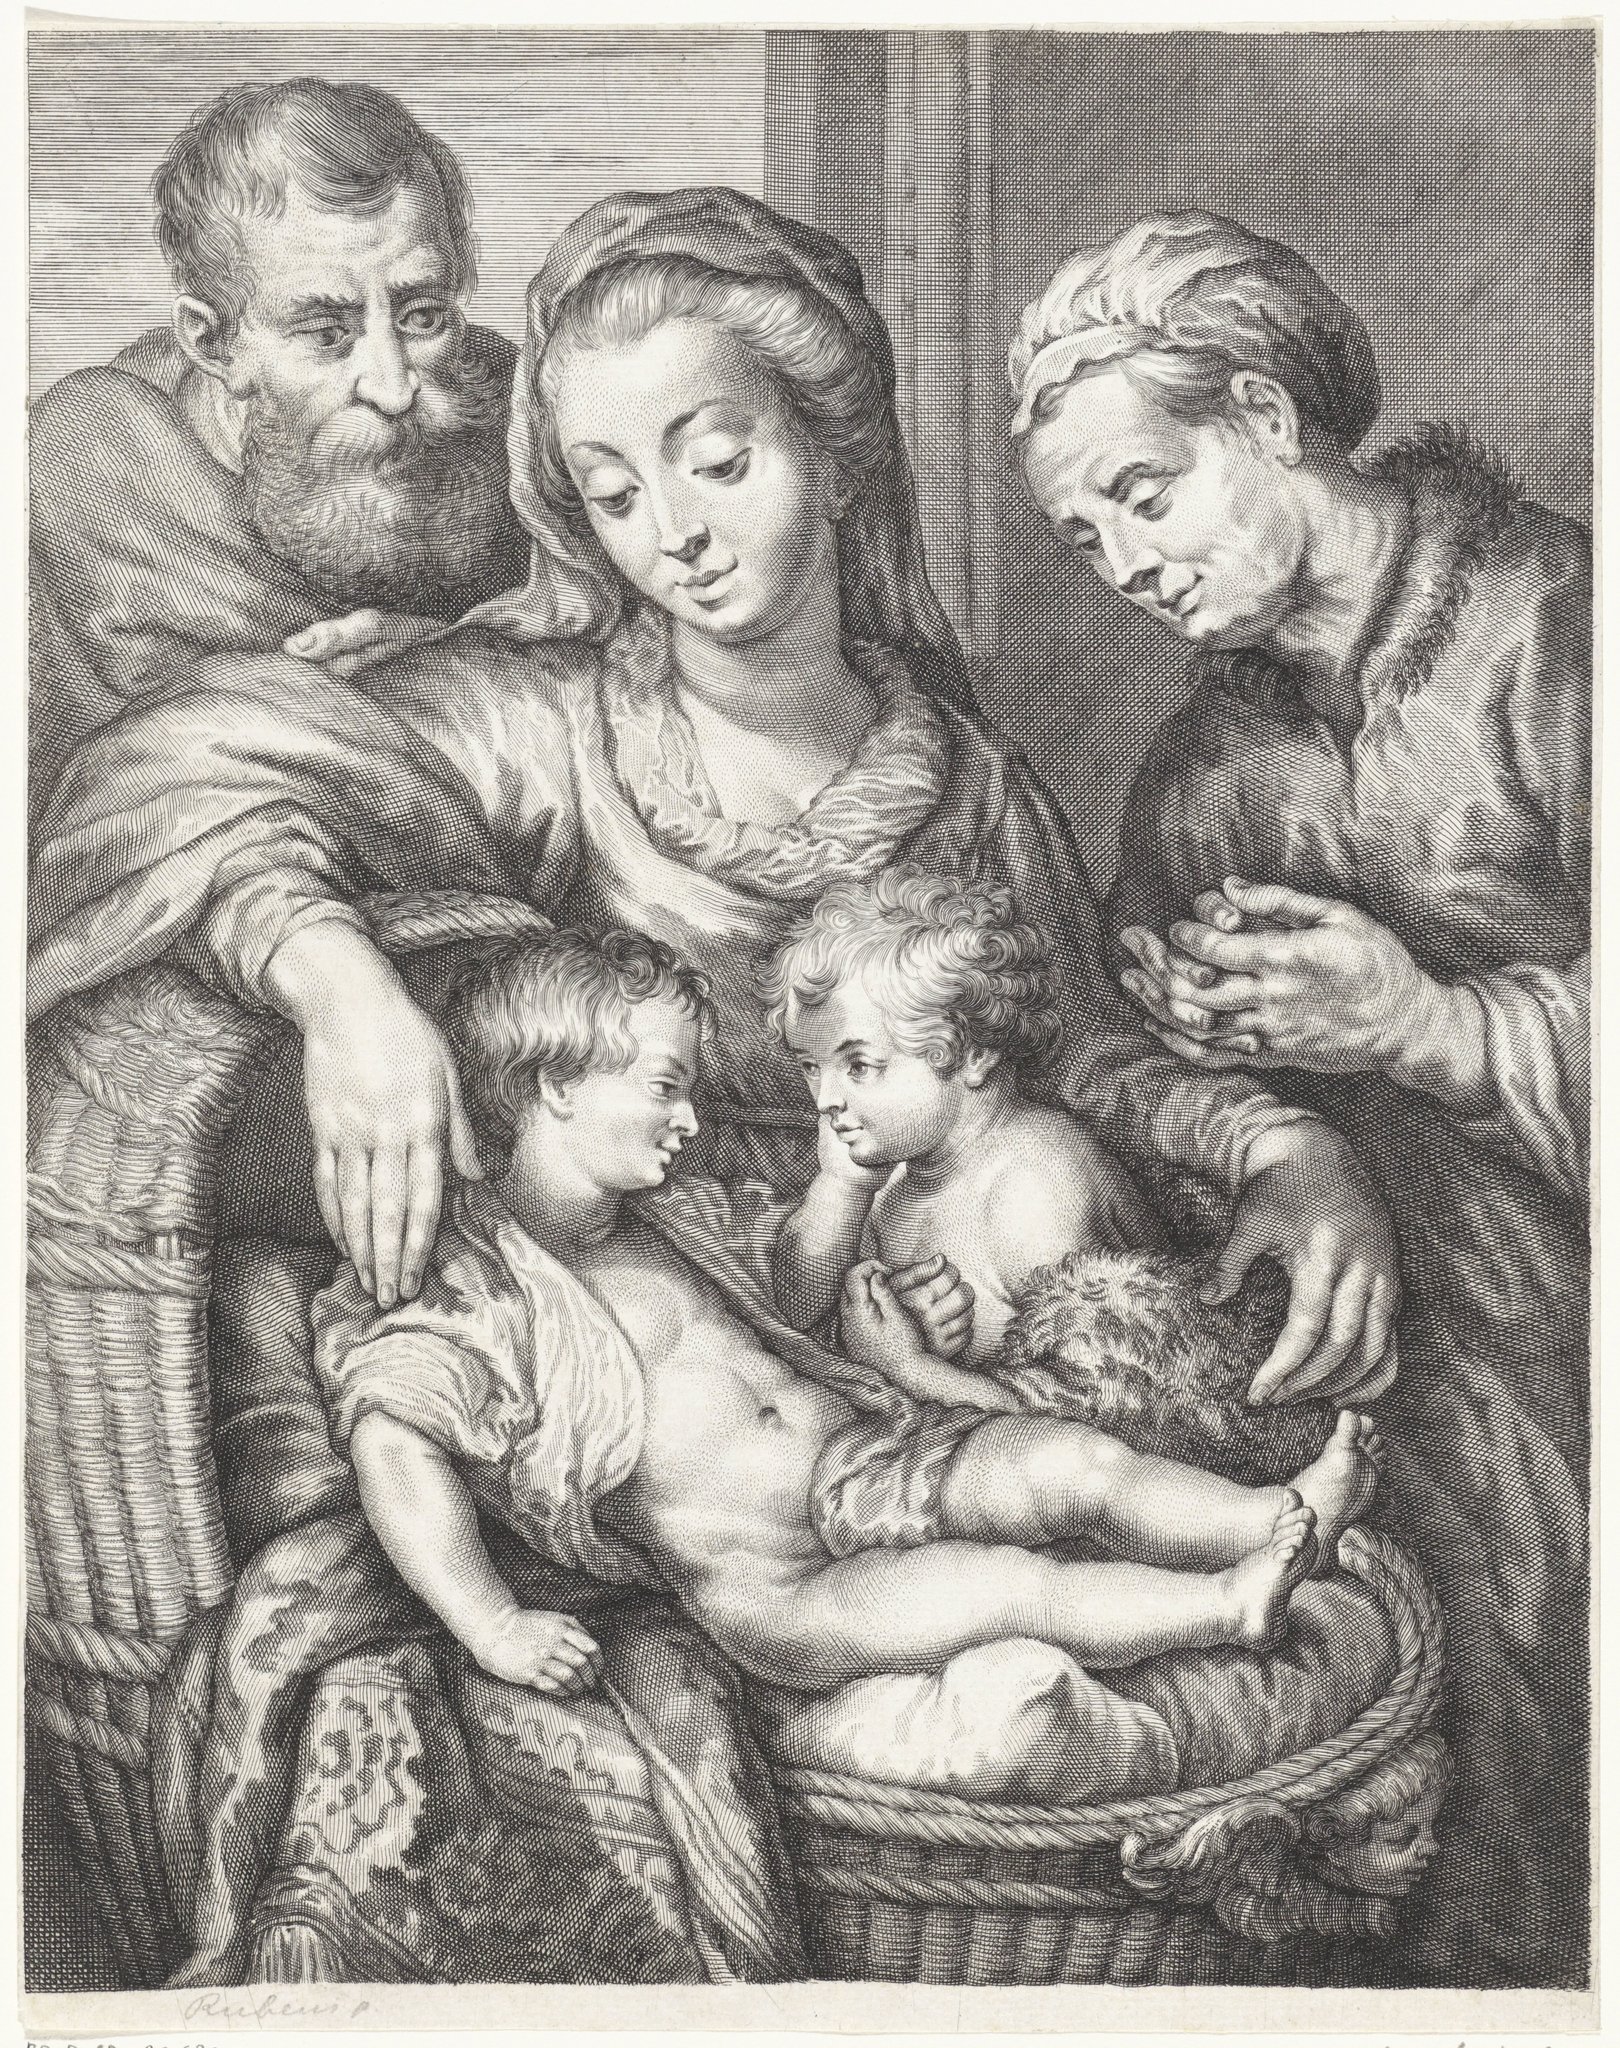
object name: print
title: Heilige Familie met Elisabet en Johannes de Doper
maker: Anonymous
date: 1615-1690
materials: paper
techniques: engraving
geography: low countries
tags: holy family with john the baptist, elisabeth present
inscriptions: collector's mark: Lugt 240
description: Het Christuskind ligt in een mand. Hij raakt Johannes de Doper aan, die naast hem staat. Achter hen Maria. Links staat Jozef en rechts Elisabet.